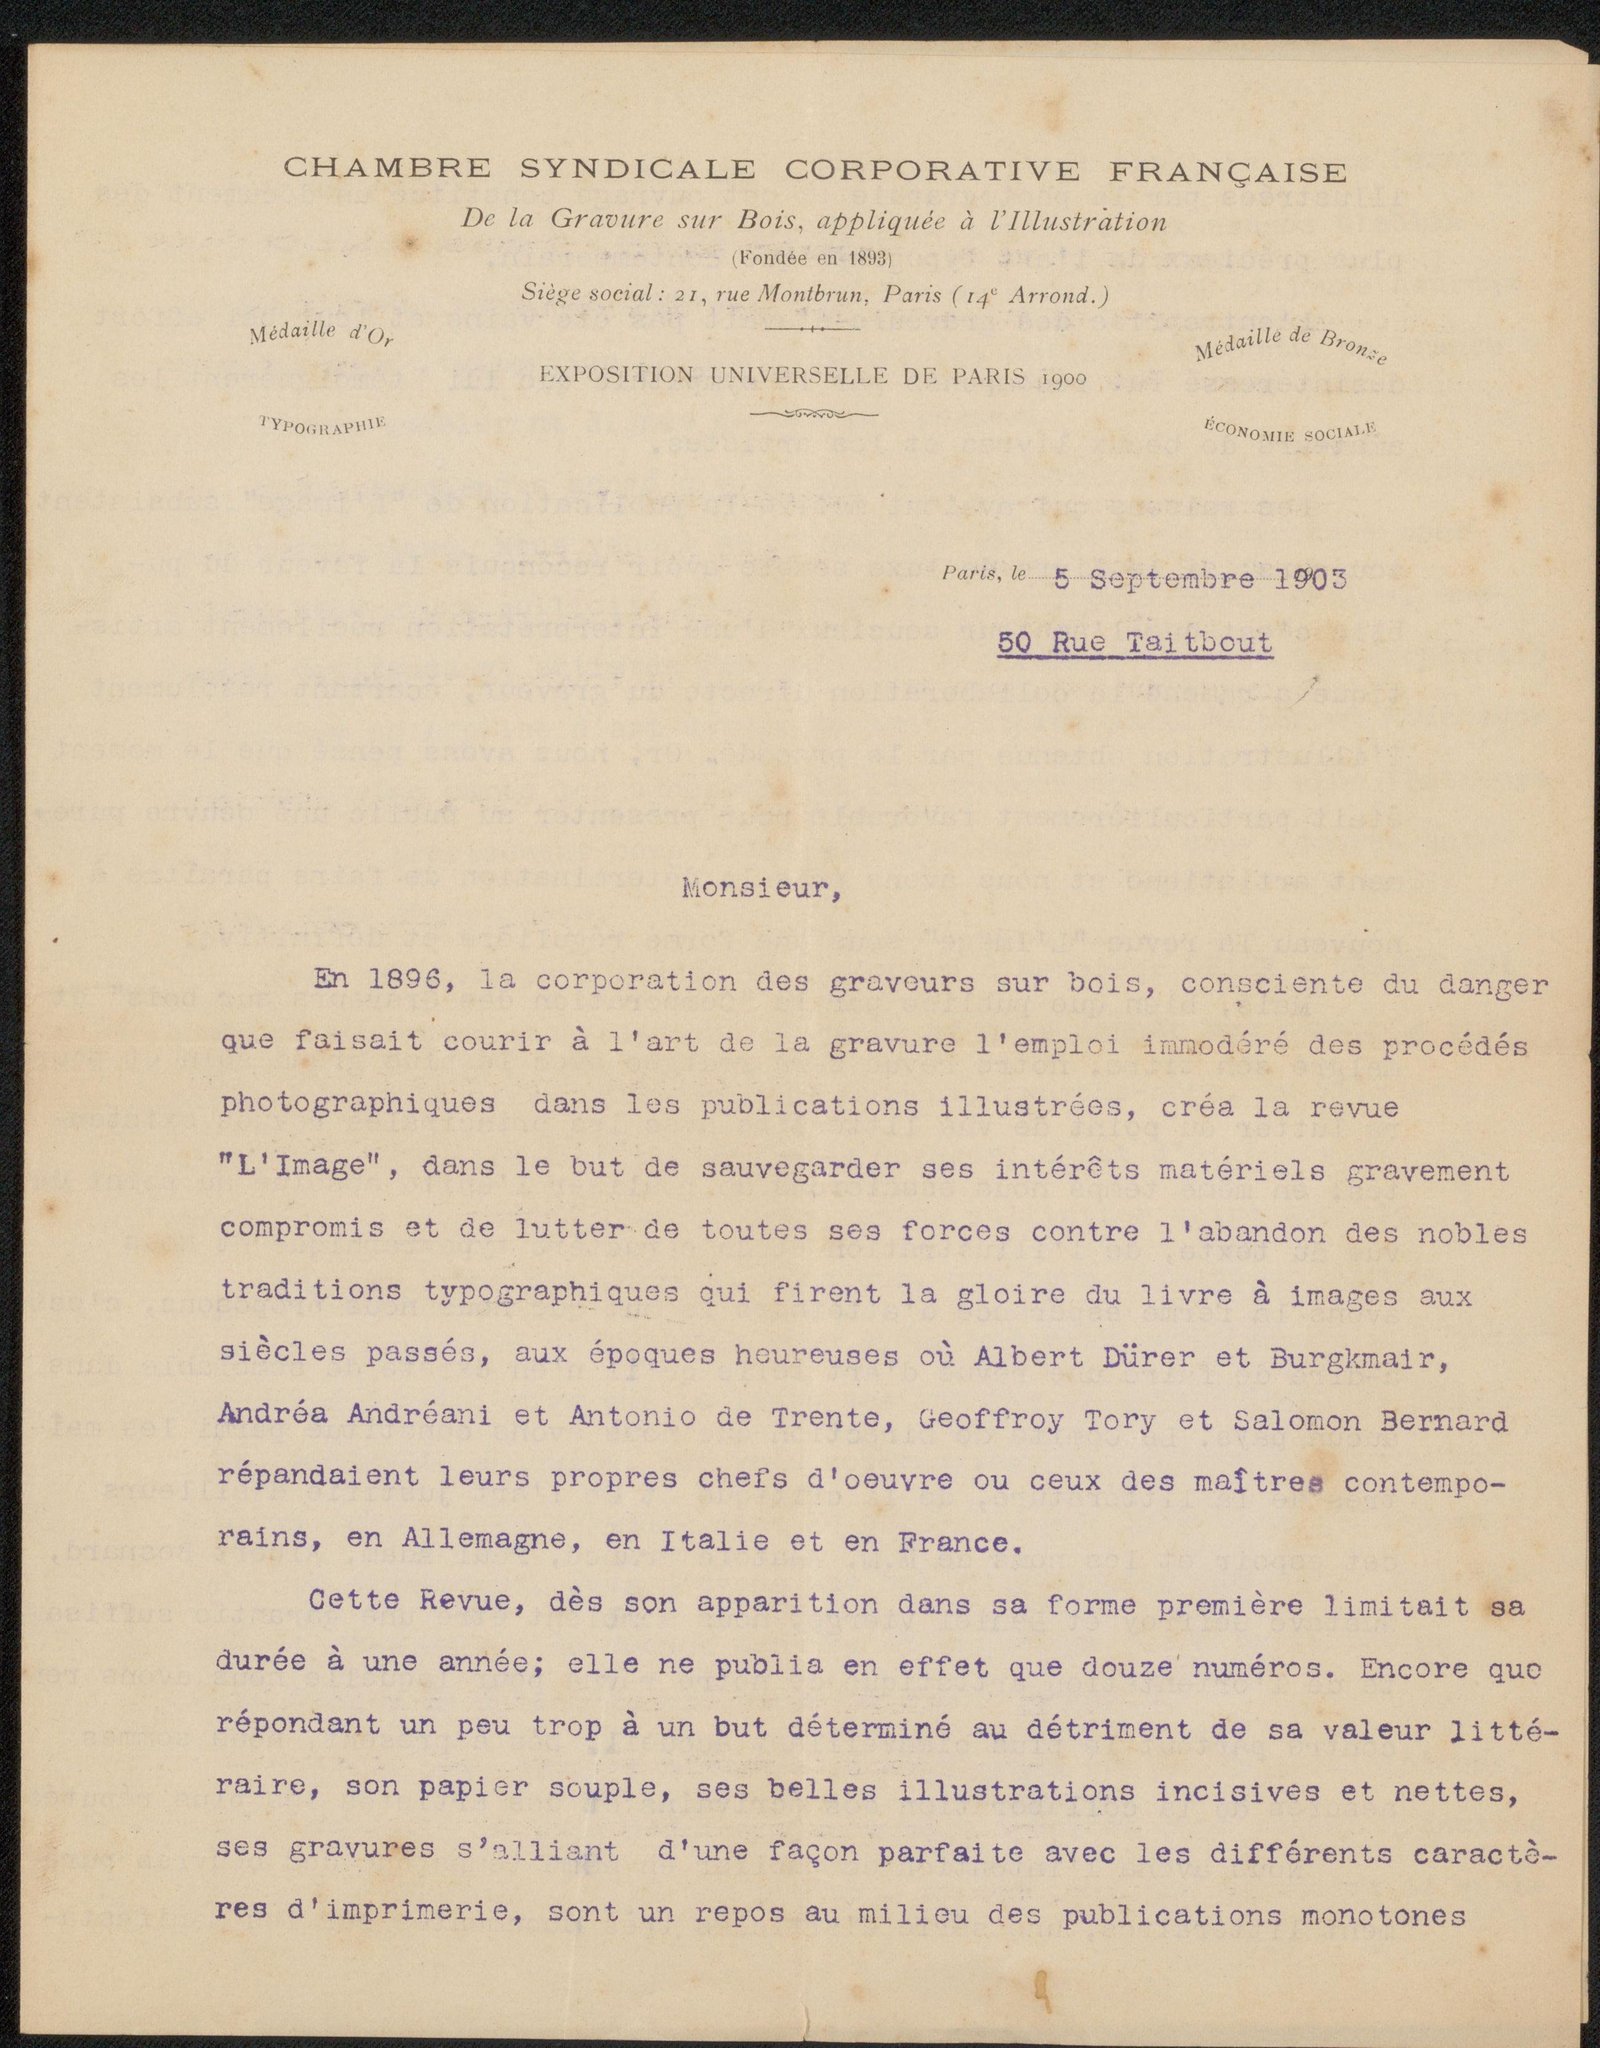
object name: letter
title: Brief aan Philip Zilcken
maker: d. ruffe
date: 1903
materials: paper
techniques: printing, typewriting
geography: paris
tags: julius meier-graefe, the hague, painter, draughtsman, philip zilcken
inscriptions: collector's mark: ‘RPK’